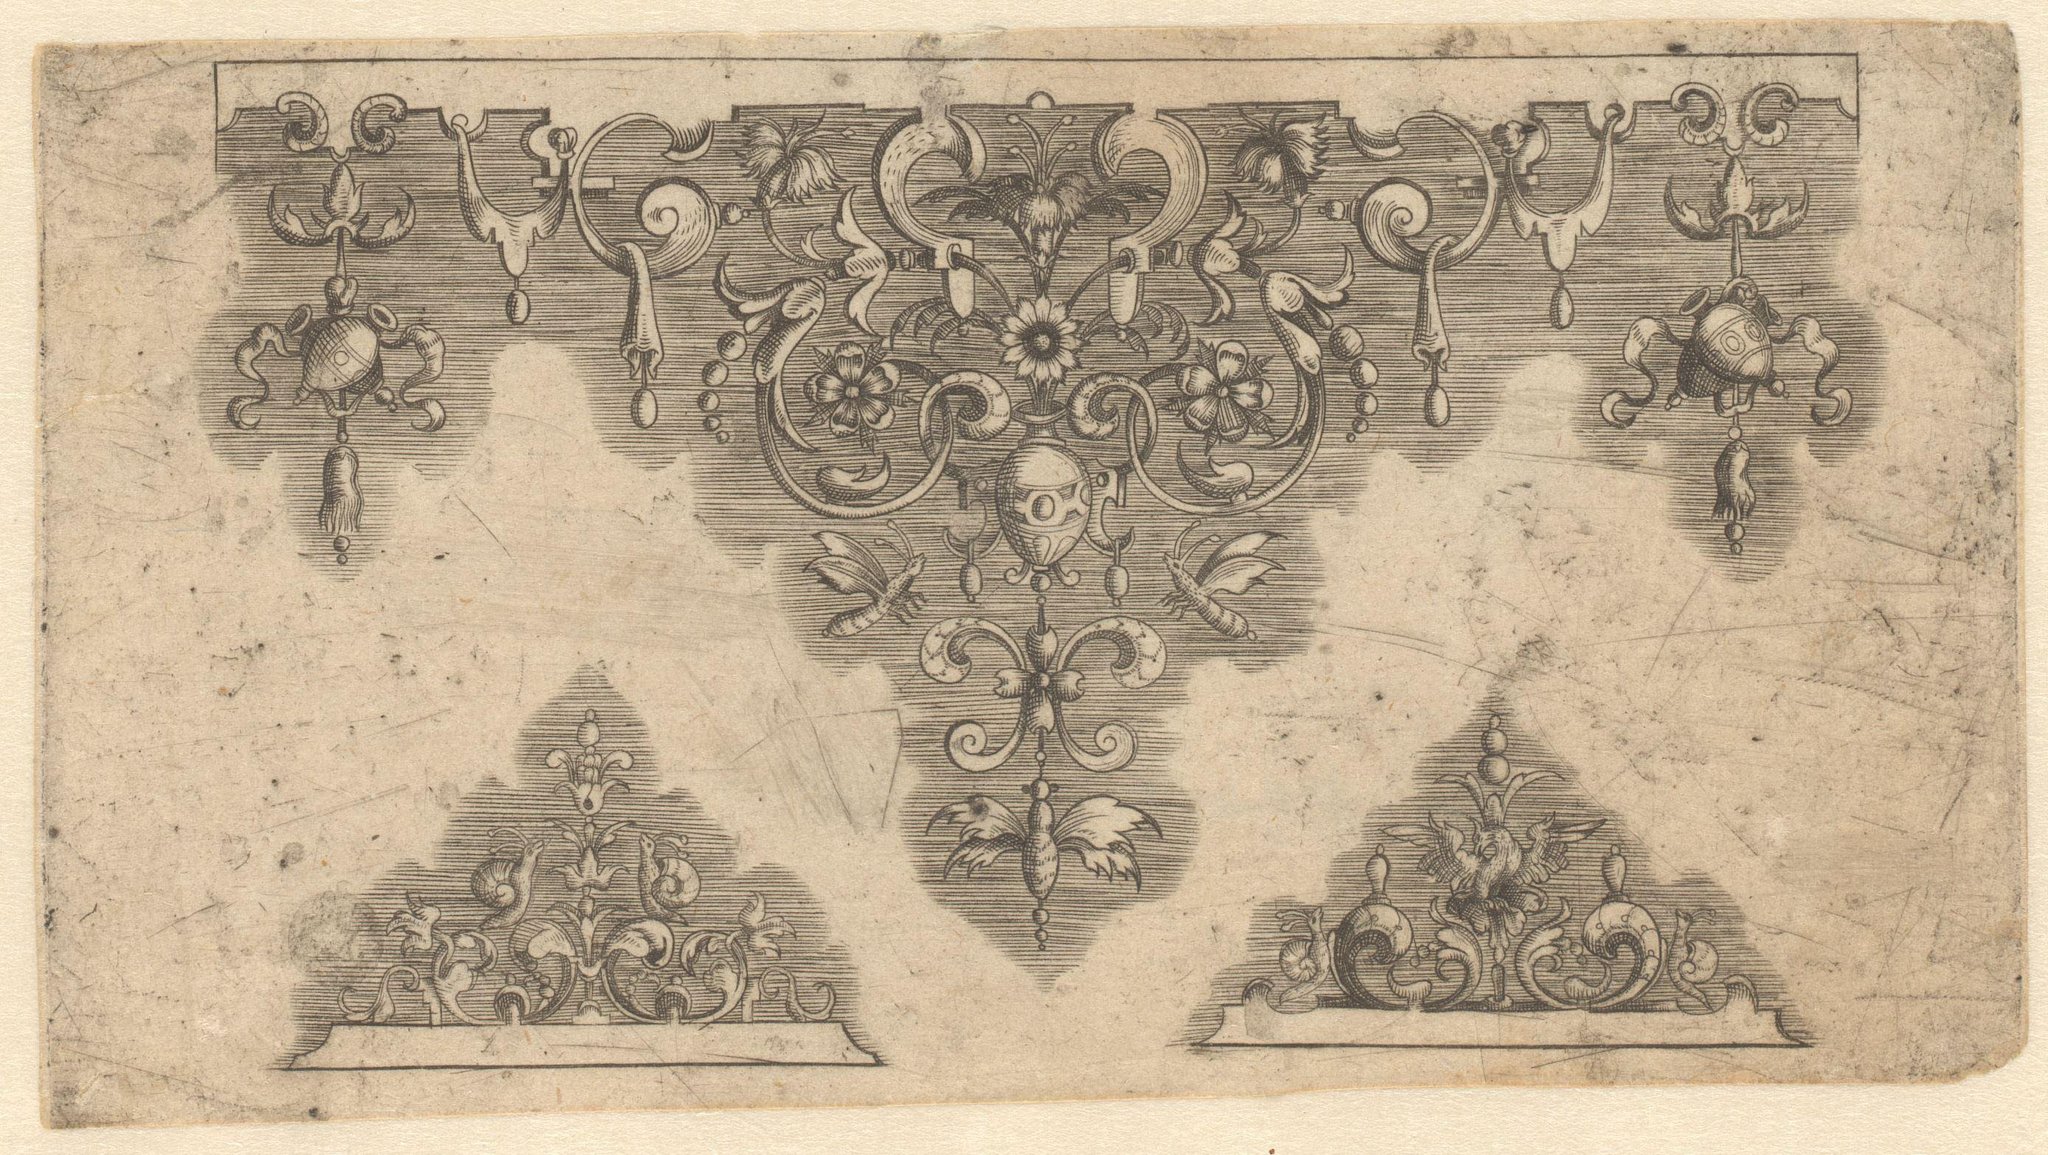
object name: print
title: Drie randontwerpen voor zilveren bekers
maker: michiel le blon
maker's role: print maker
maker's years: 1587-1656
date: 1597-1656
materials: paper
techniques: engraving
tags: ornaments ~ art, animals, foliage ~ ornament, other ornament derived from animal forms, molluscs: snail, ornament ~ festoon, garland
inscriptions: collector's mark: Lugt 2760, collector's mark: Lugt 2228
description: Voorbeelden voor gegraveerde decoratieranden van bekers in de vorm van driehoeken bestaande uit ranken, Schweifwerk, guirlandes en dieren.